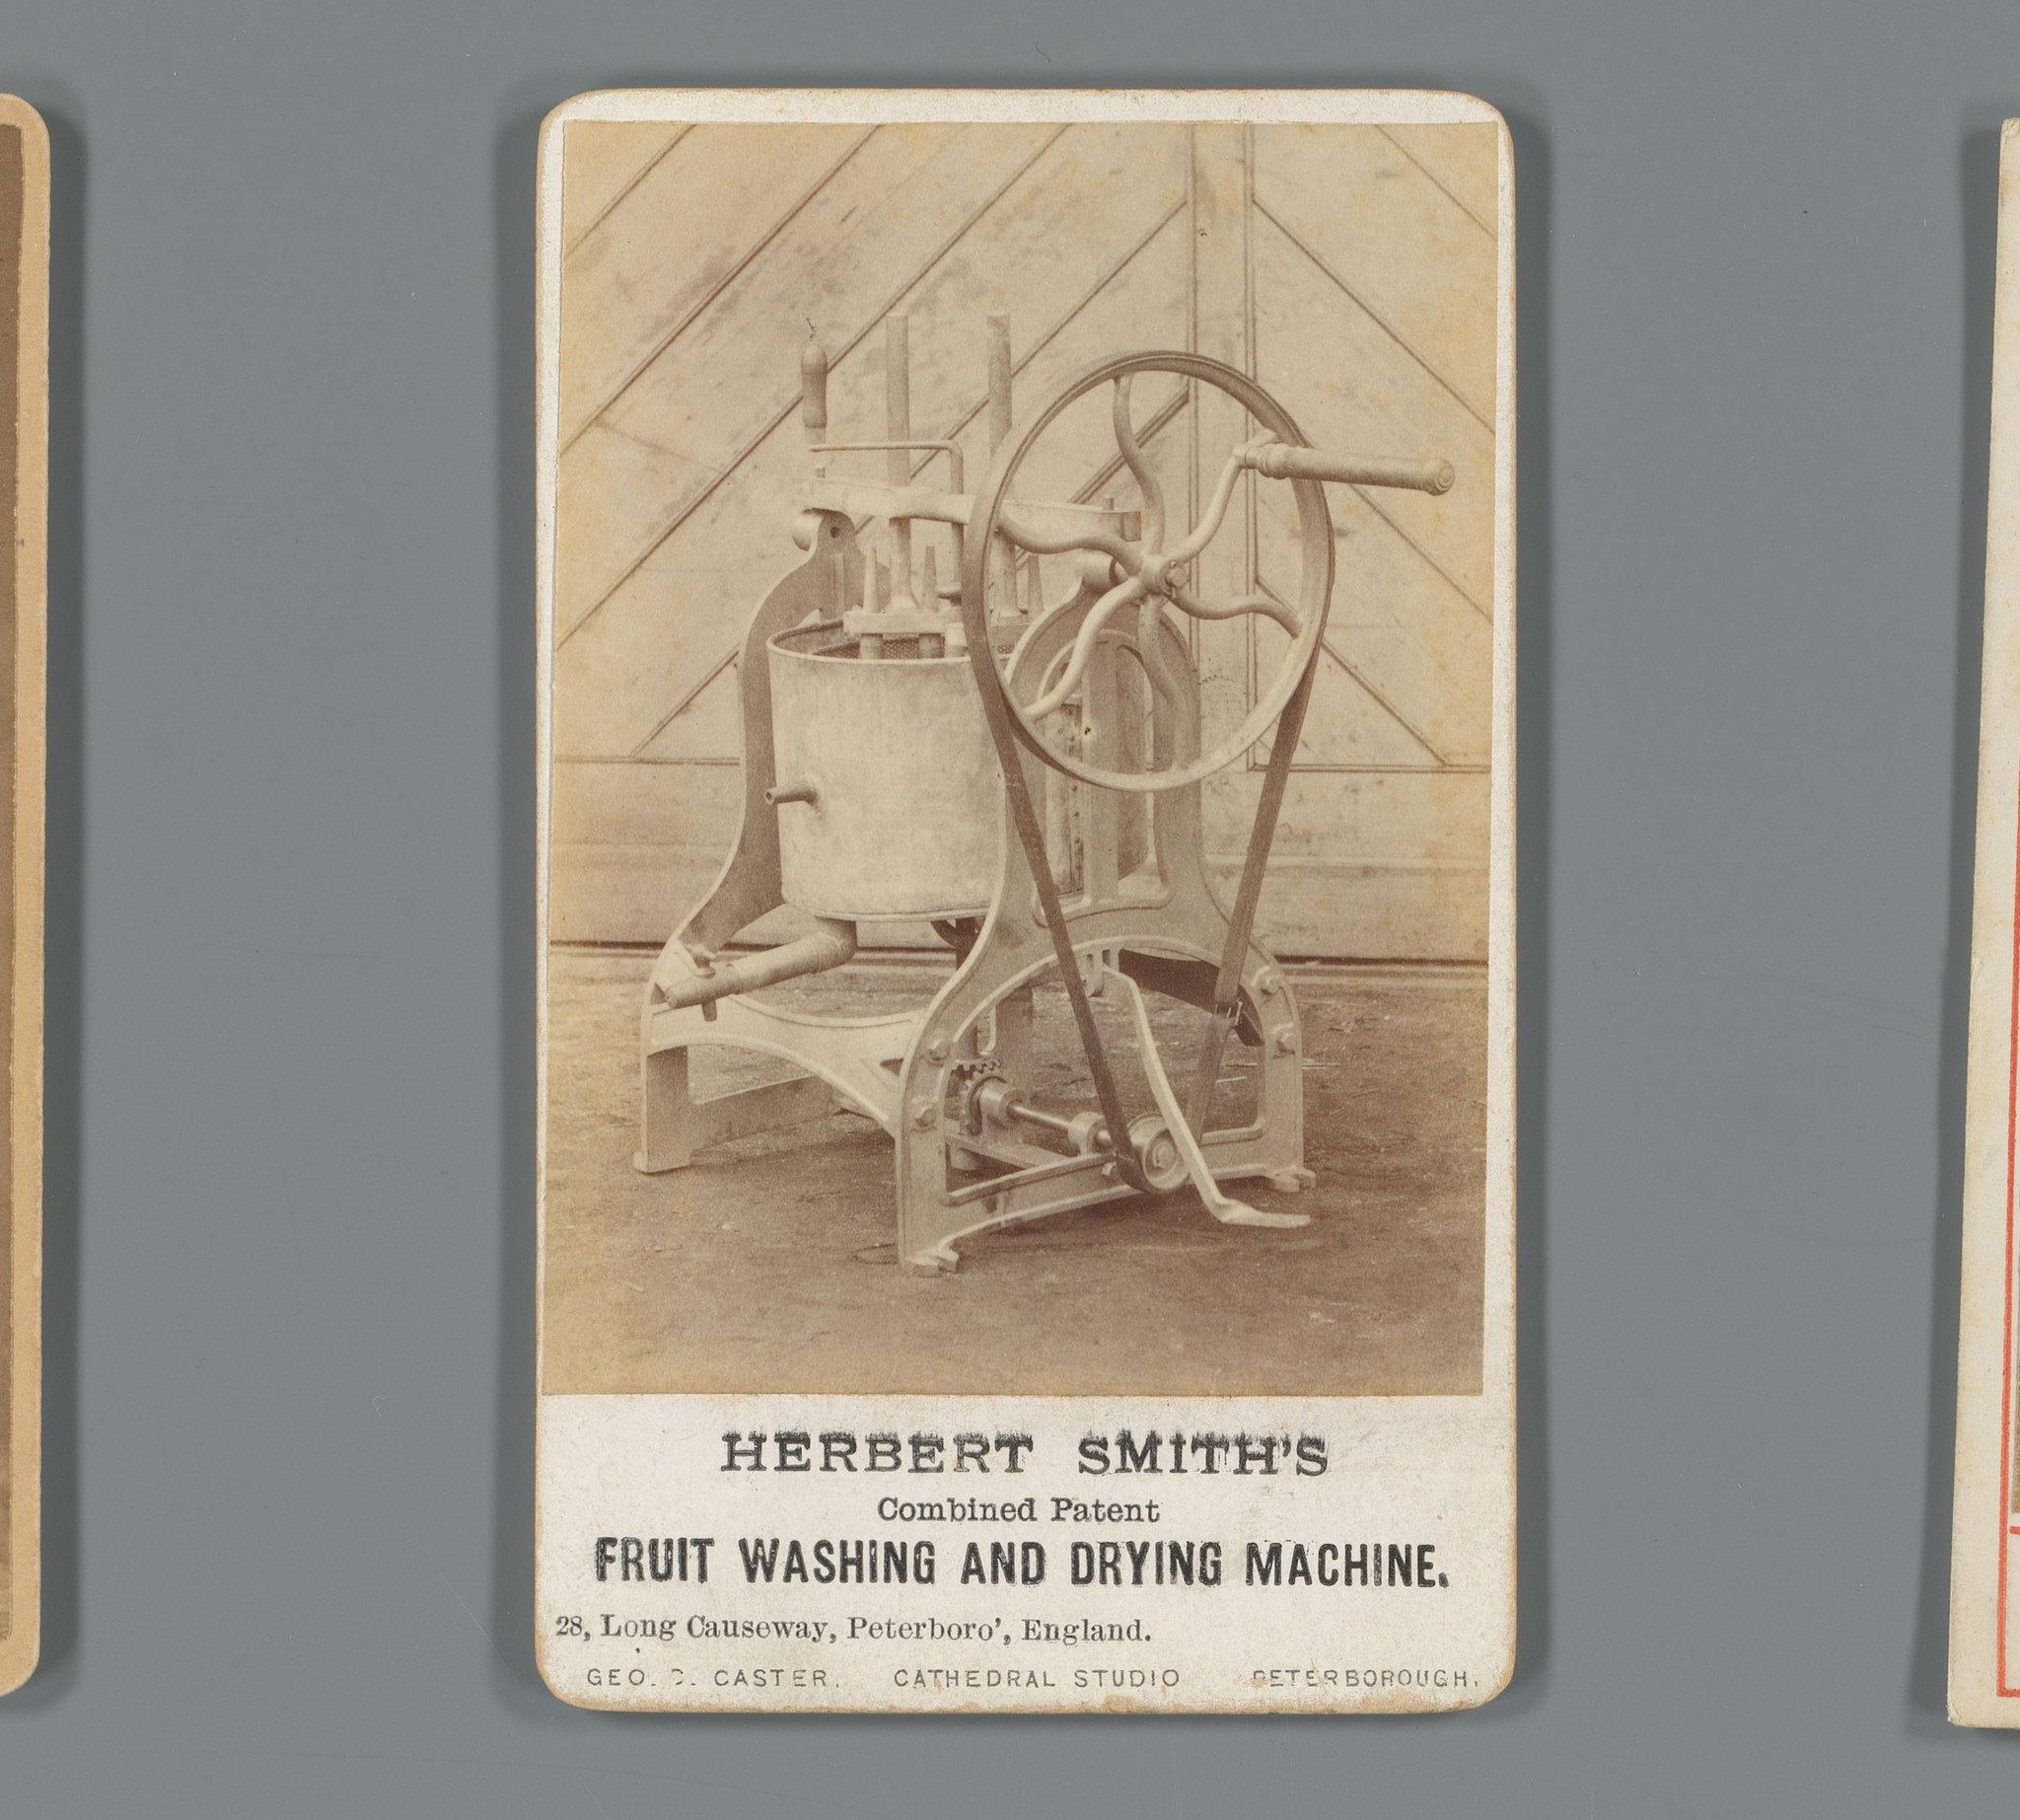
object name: photograph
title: Was- en droogmachine voor fruit van Herbert Smith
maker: george coborn caster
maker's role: fotograaf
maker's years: 1850-1914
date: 1850-1914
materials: cardboard, photographic support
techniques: albumen print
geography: peterborough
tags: advertising, machines; parts of machines; tools and appliances, cleaning (food)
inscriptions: inscription: ‘HERBERT SMITH'S/ Combined Patent/ FRUIT WASHING AND DRYING MACHINE./ 28, Long Causeway, Peterboro', England./ GEO. C. CASTER CATHEDRAL STUDIO PETERBOROUGH.’, inscription: ‘WHEN RE-ORDERING PLEASE QUOTE No...../ The Cathedral Studio/ Artist & Photographer,/ Miniature &/ Portrait Painter,/ Geo C. Caster/ Cathedral Gateway/ Peterborough/ Negatives Kept,/ Copies can always be had./ PORTRAITS ENLARGED TO ANY SIZE/ & FINISHED IN OILS, WATER COLOURS OR CRAYONS.’